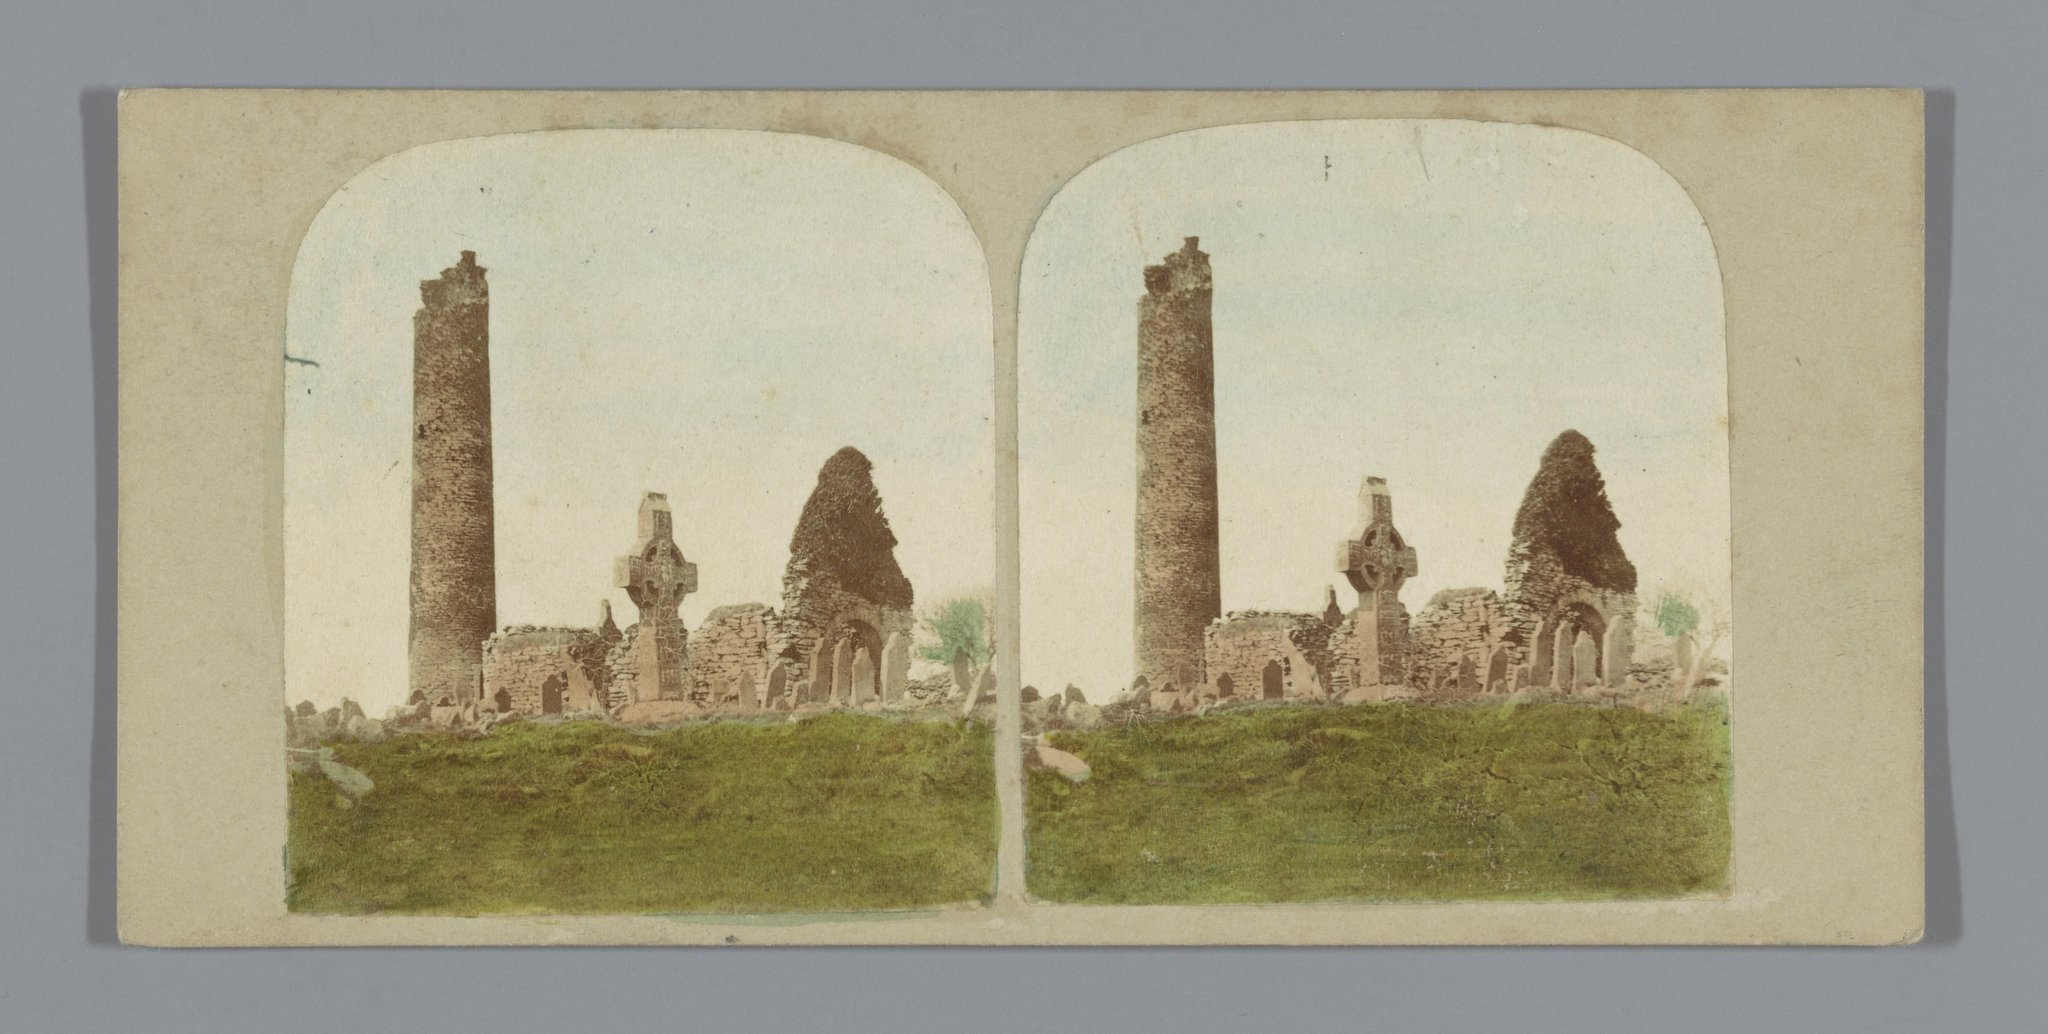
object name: stereograph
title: Gezicht op de ruïne van Monasterboice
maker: Anonymous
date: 1850-1880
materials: cardboard, photographic support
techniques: albumen print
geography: monasterboice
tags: ruin of church, monastery, etc.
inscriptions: number: ‘29.’, inscription: ‘General view of the Antiquities of Monasterboice, County Louth. Ireland.’